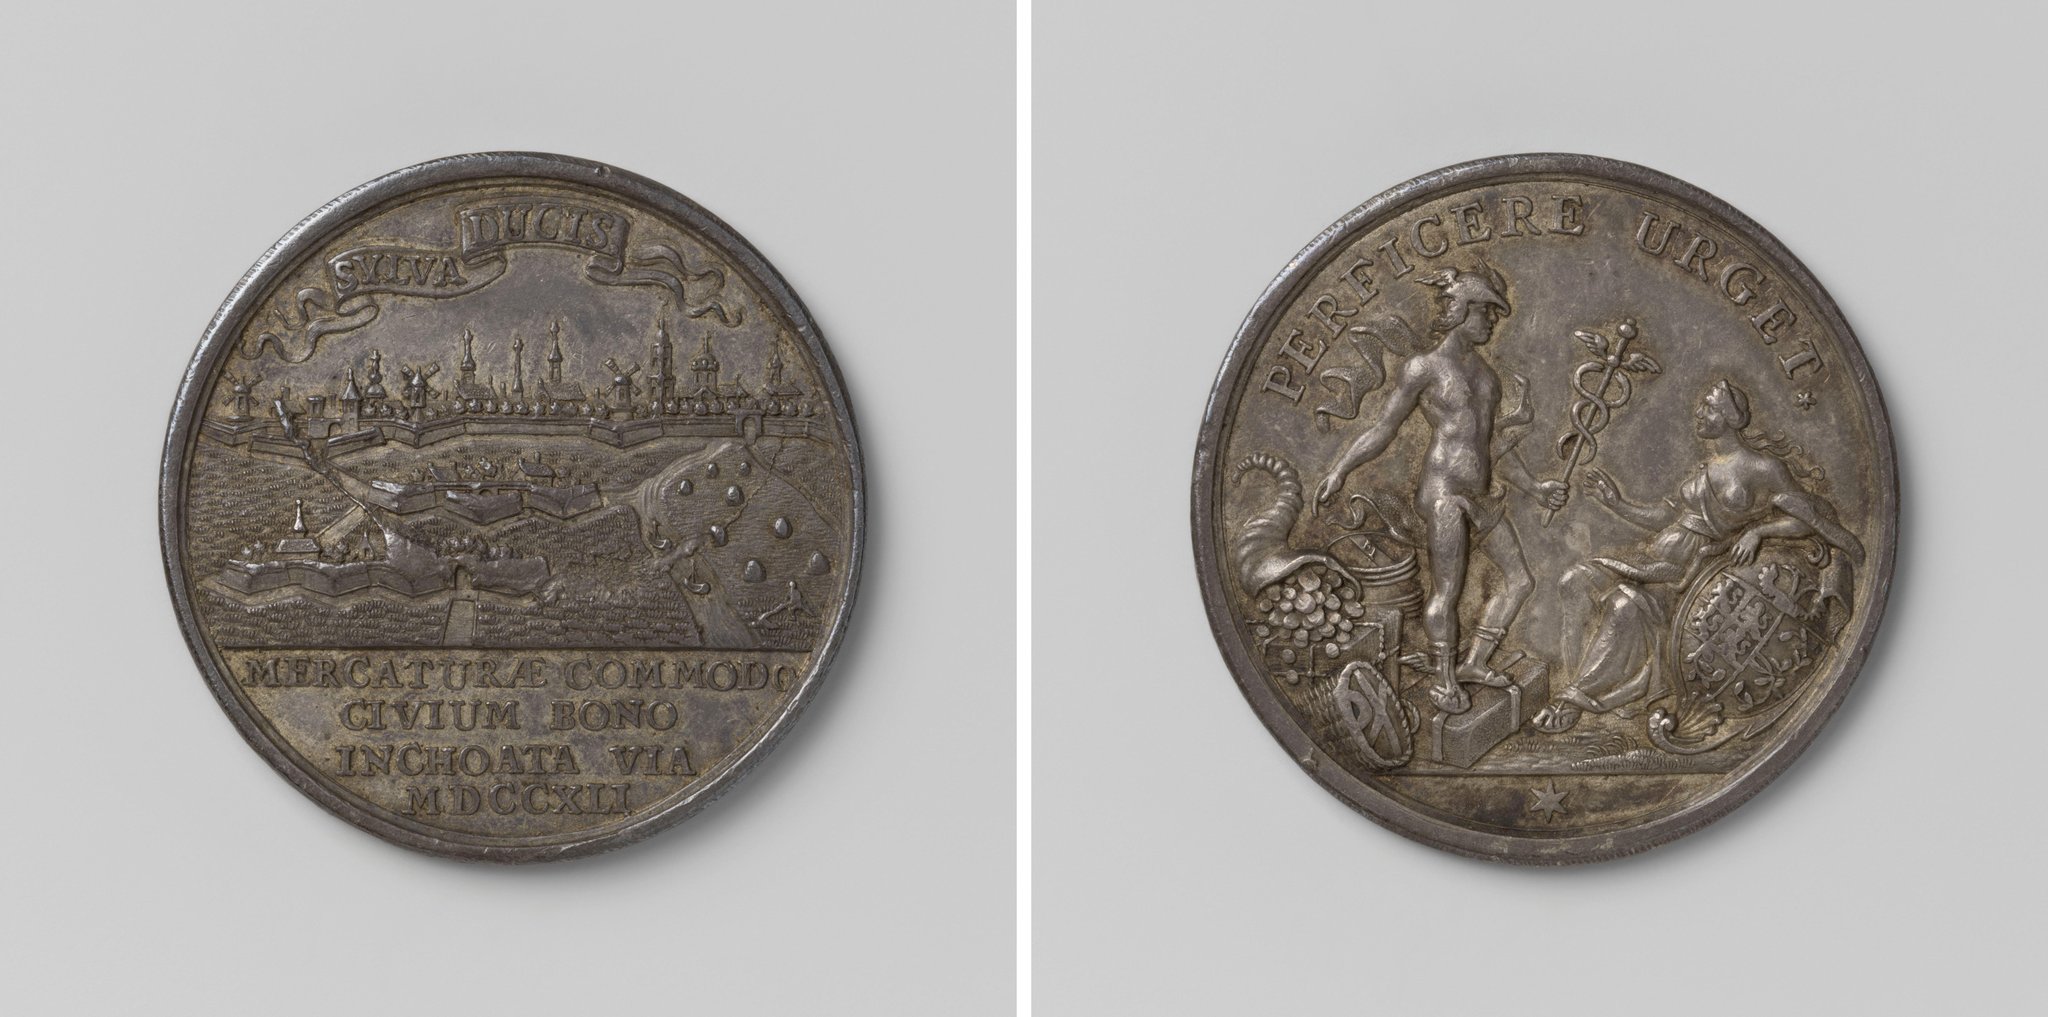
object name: council medal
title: 's-Hertogenbosch, vroedschapspenning op de aanleg van de steenweg van 's-Hertogenbosch naar Eindhoven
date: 1741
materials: silver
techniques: striking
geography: den bosch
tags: den bosch